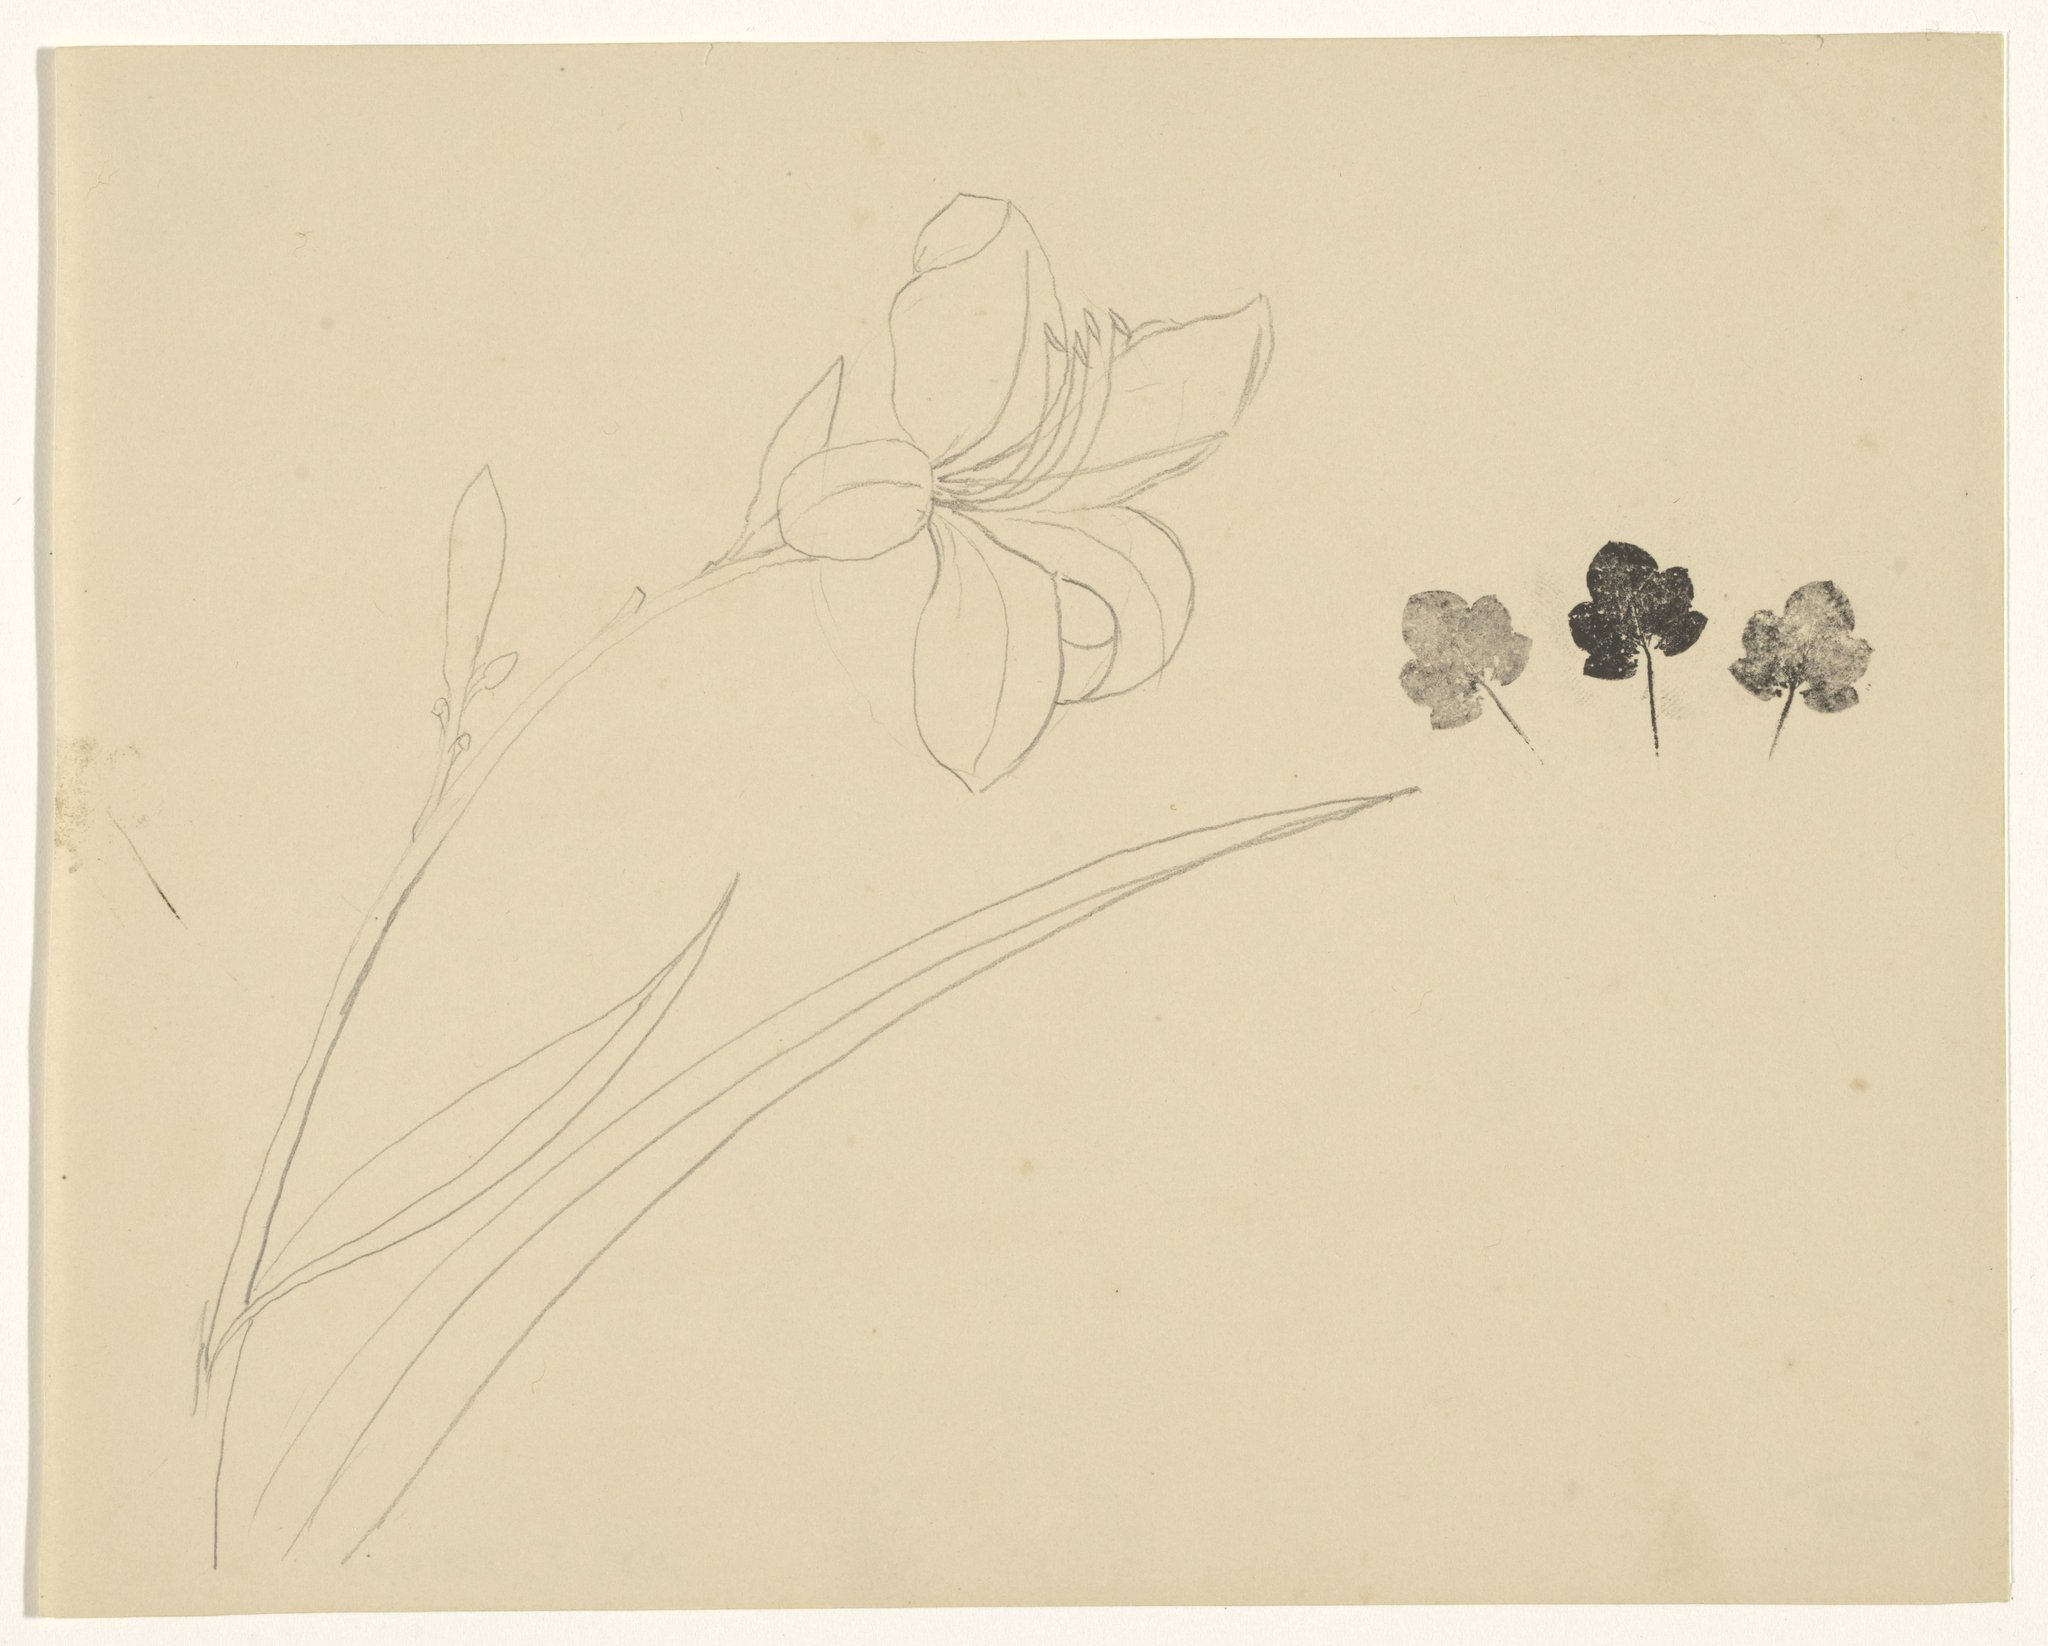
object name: drawing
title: Een lelie en drie afdrukken van een blad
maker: franz jakob kreuter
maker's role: architect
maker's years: 1813-1889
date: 1835-1860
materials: paper, pencil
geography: munich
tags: flowers: lily